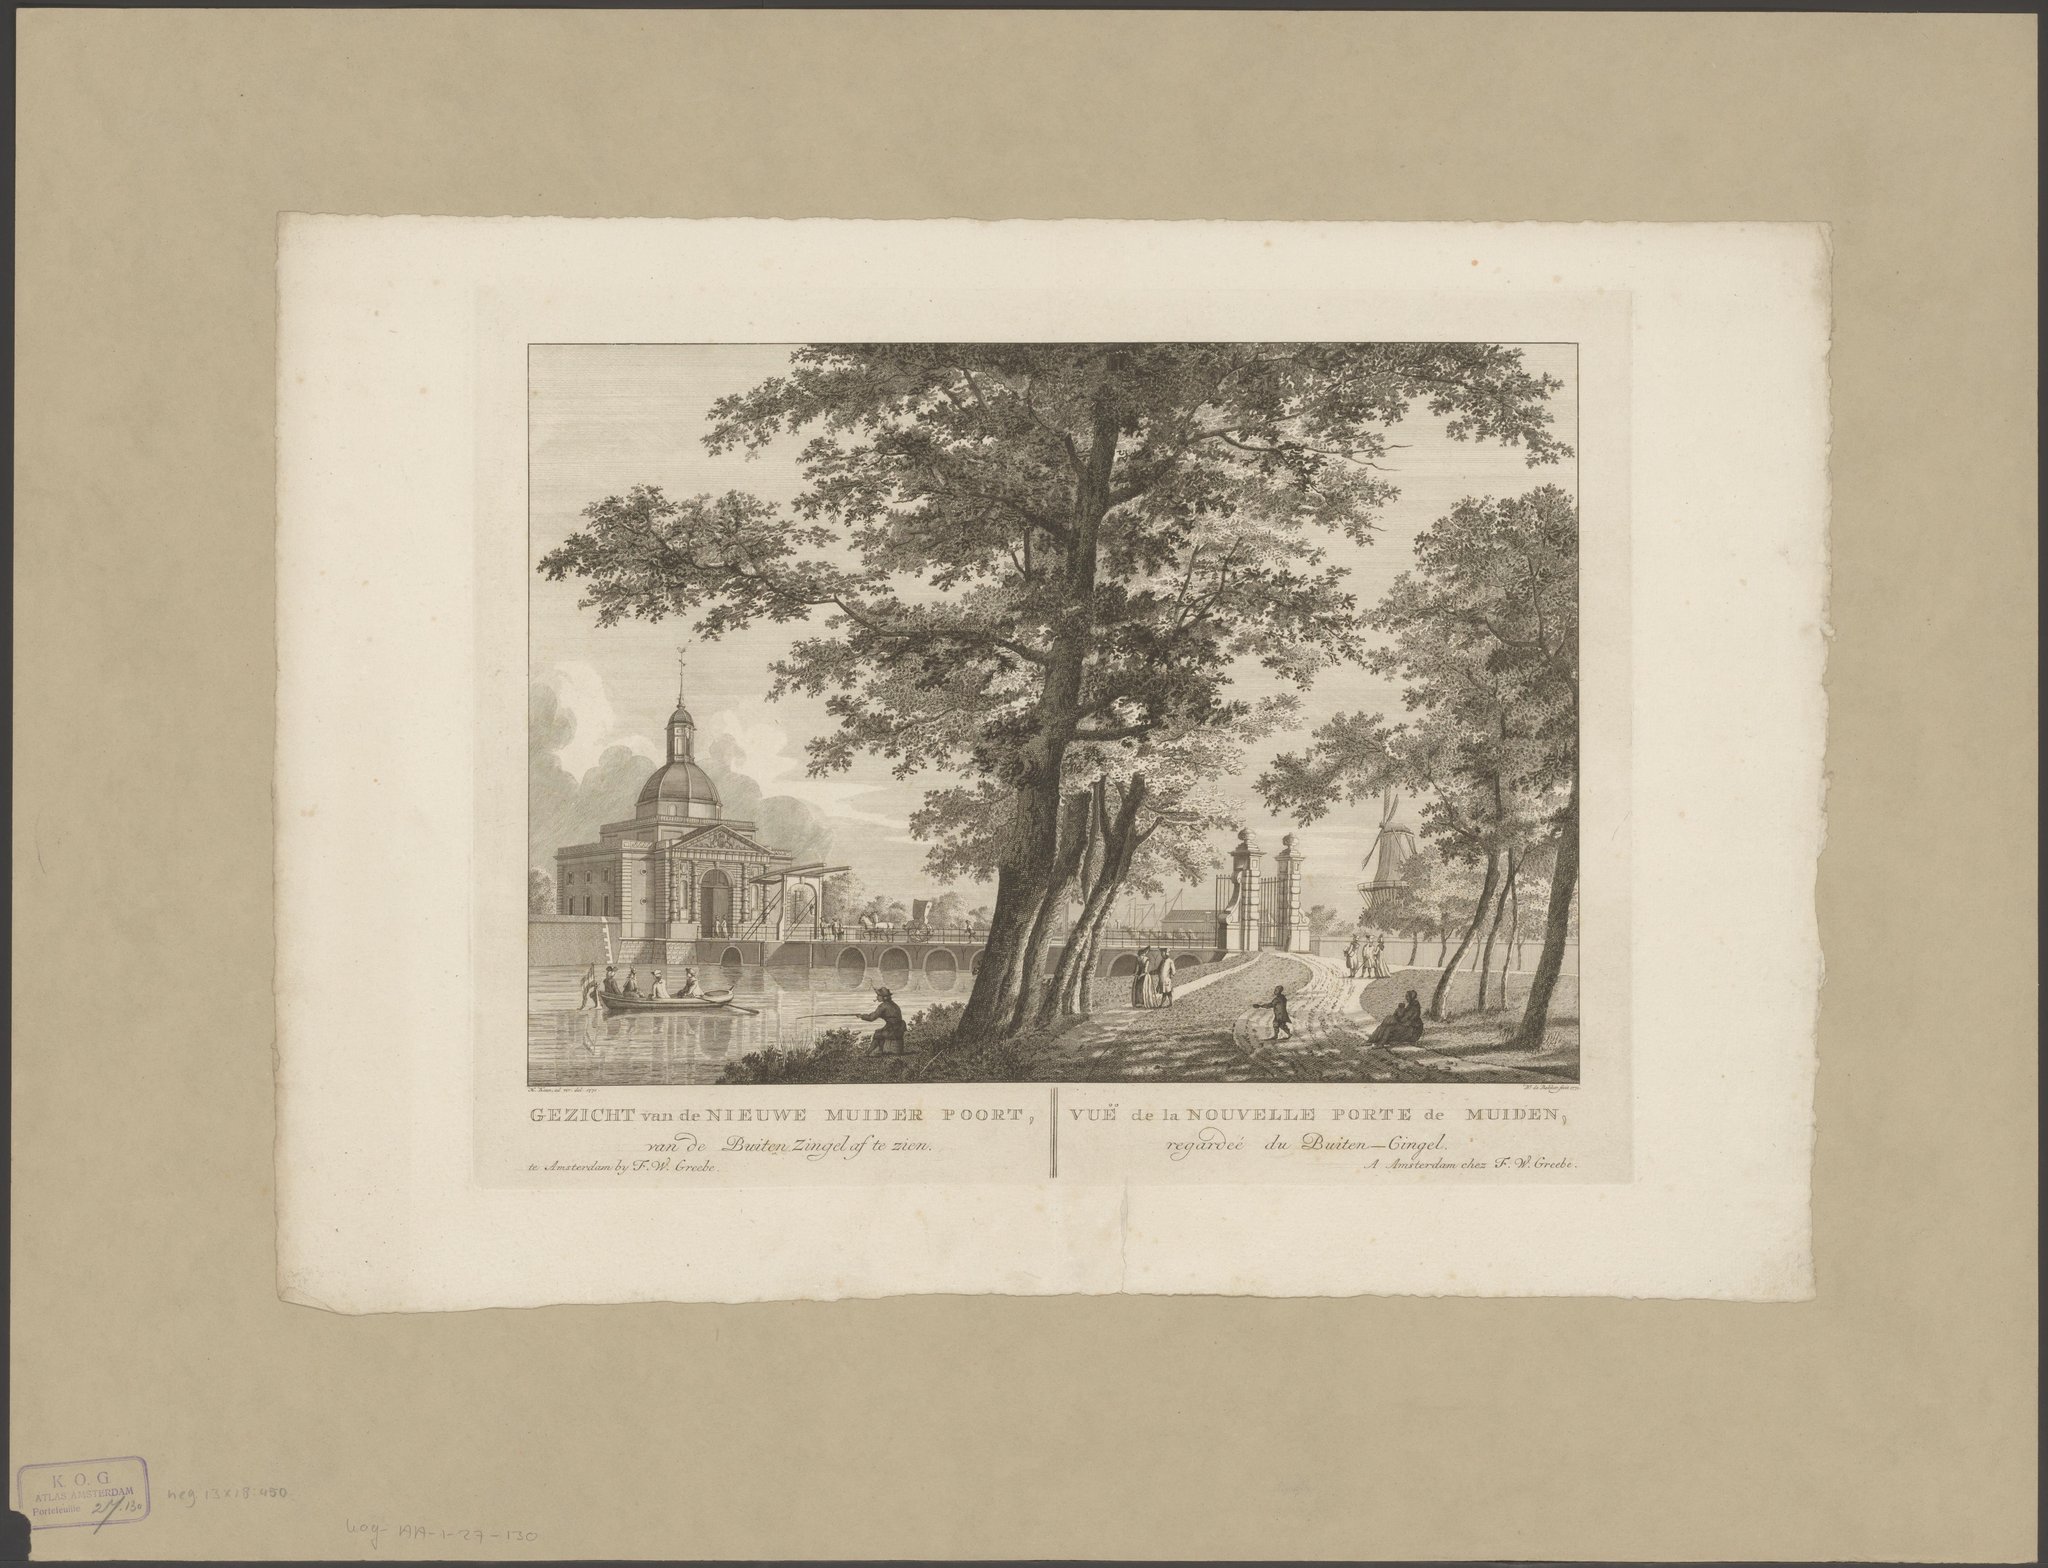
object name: print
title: Gezicht op Tweede Muiderpoort te Amsterdam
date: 1771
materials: paper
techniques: engraving, etching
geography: amsterdam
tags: bridge in city across river, canal, etc. (+ city(-scape) with figures, staffage), rowing facing backward, pulling, canals, waters (in city), windmill, city-gate, angling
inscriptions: collector's mark: Lugt 1641b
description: Gezicht op de in 1770 gebouwde Tweede Muiderpoort te Amsterdam, gezien vanuit de stad. Gebouwd ter vervanging van een eerdere verzakte poort (zie RP-P-AO-27-18A). Voor de poort een brug met een koets en enkele figuren. Voor de brug wandelen ook enkele figuren en verkoopt een man producten vanuit een kruiwagen. In het water een schuit. Onder de voorstelling de titel in het Nederlands en Frans. Onderwerpsrubriek binnen de Atlas Amsterdam: Poorten, verzamelbladen, J. Tweede Muiderpoort.